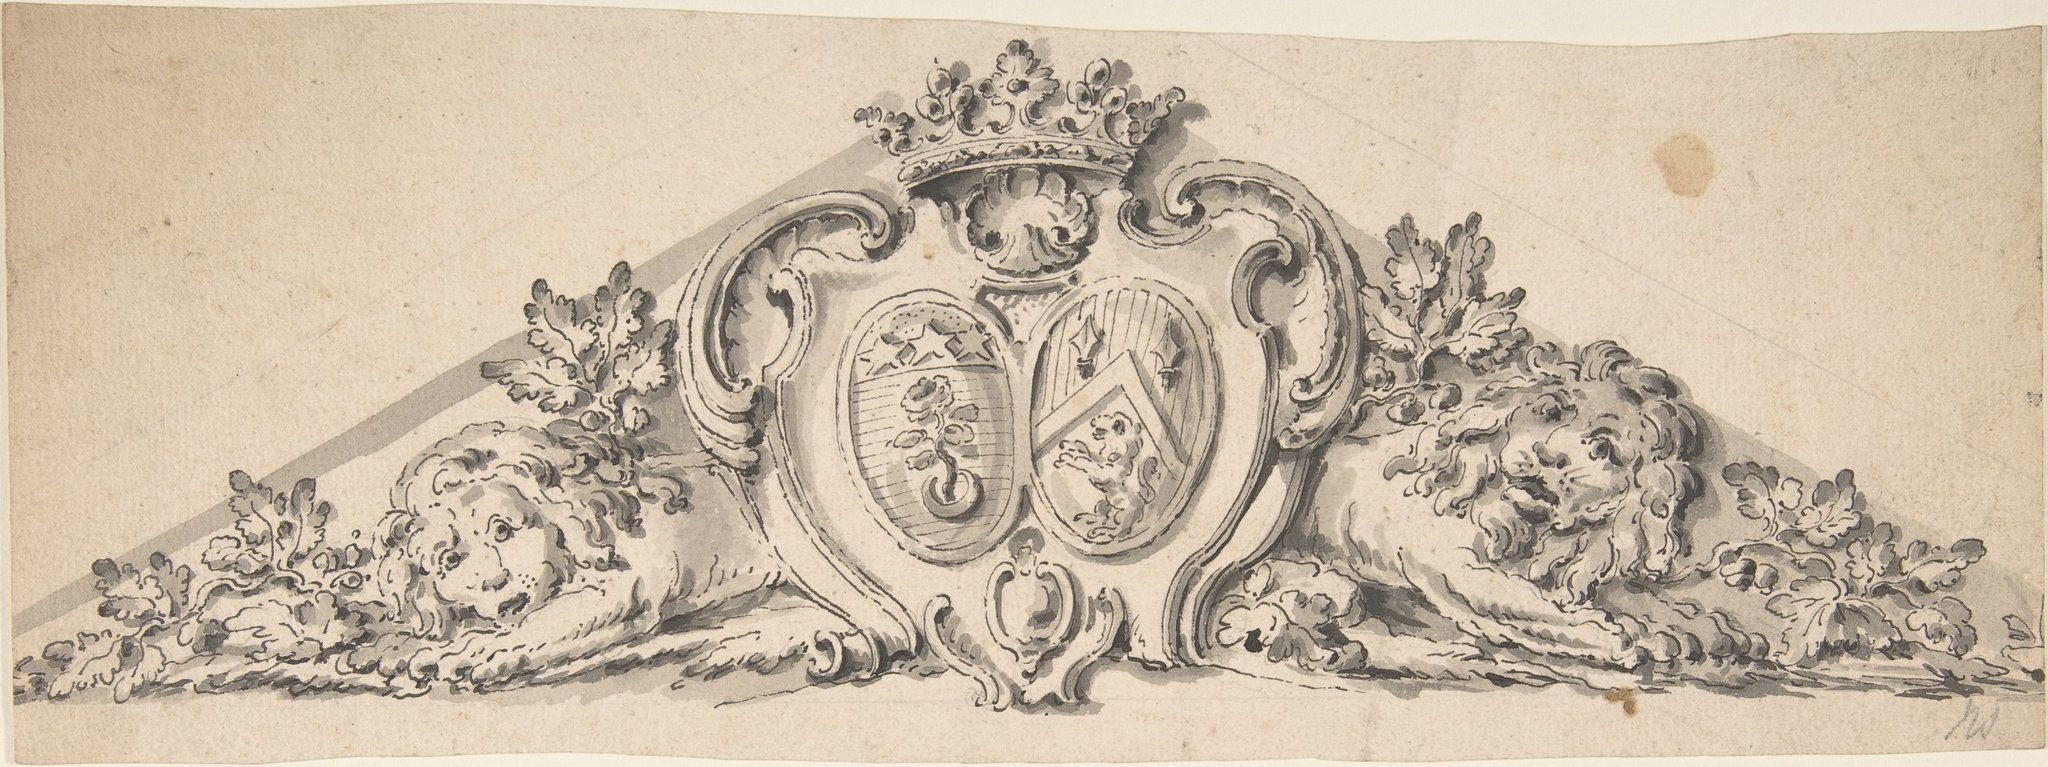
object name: drawing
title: Design for Pediment with Two Heraldic Crests, Lions and a Crown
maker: anonymous, french, 18th century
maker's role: artist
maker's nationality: french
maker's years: 1700-1800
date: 1701-1800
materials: graphite, ink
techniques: brush, pen, wash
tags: lions,coat of arms